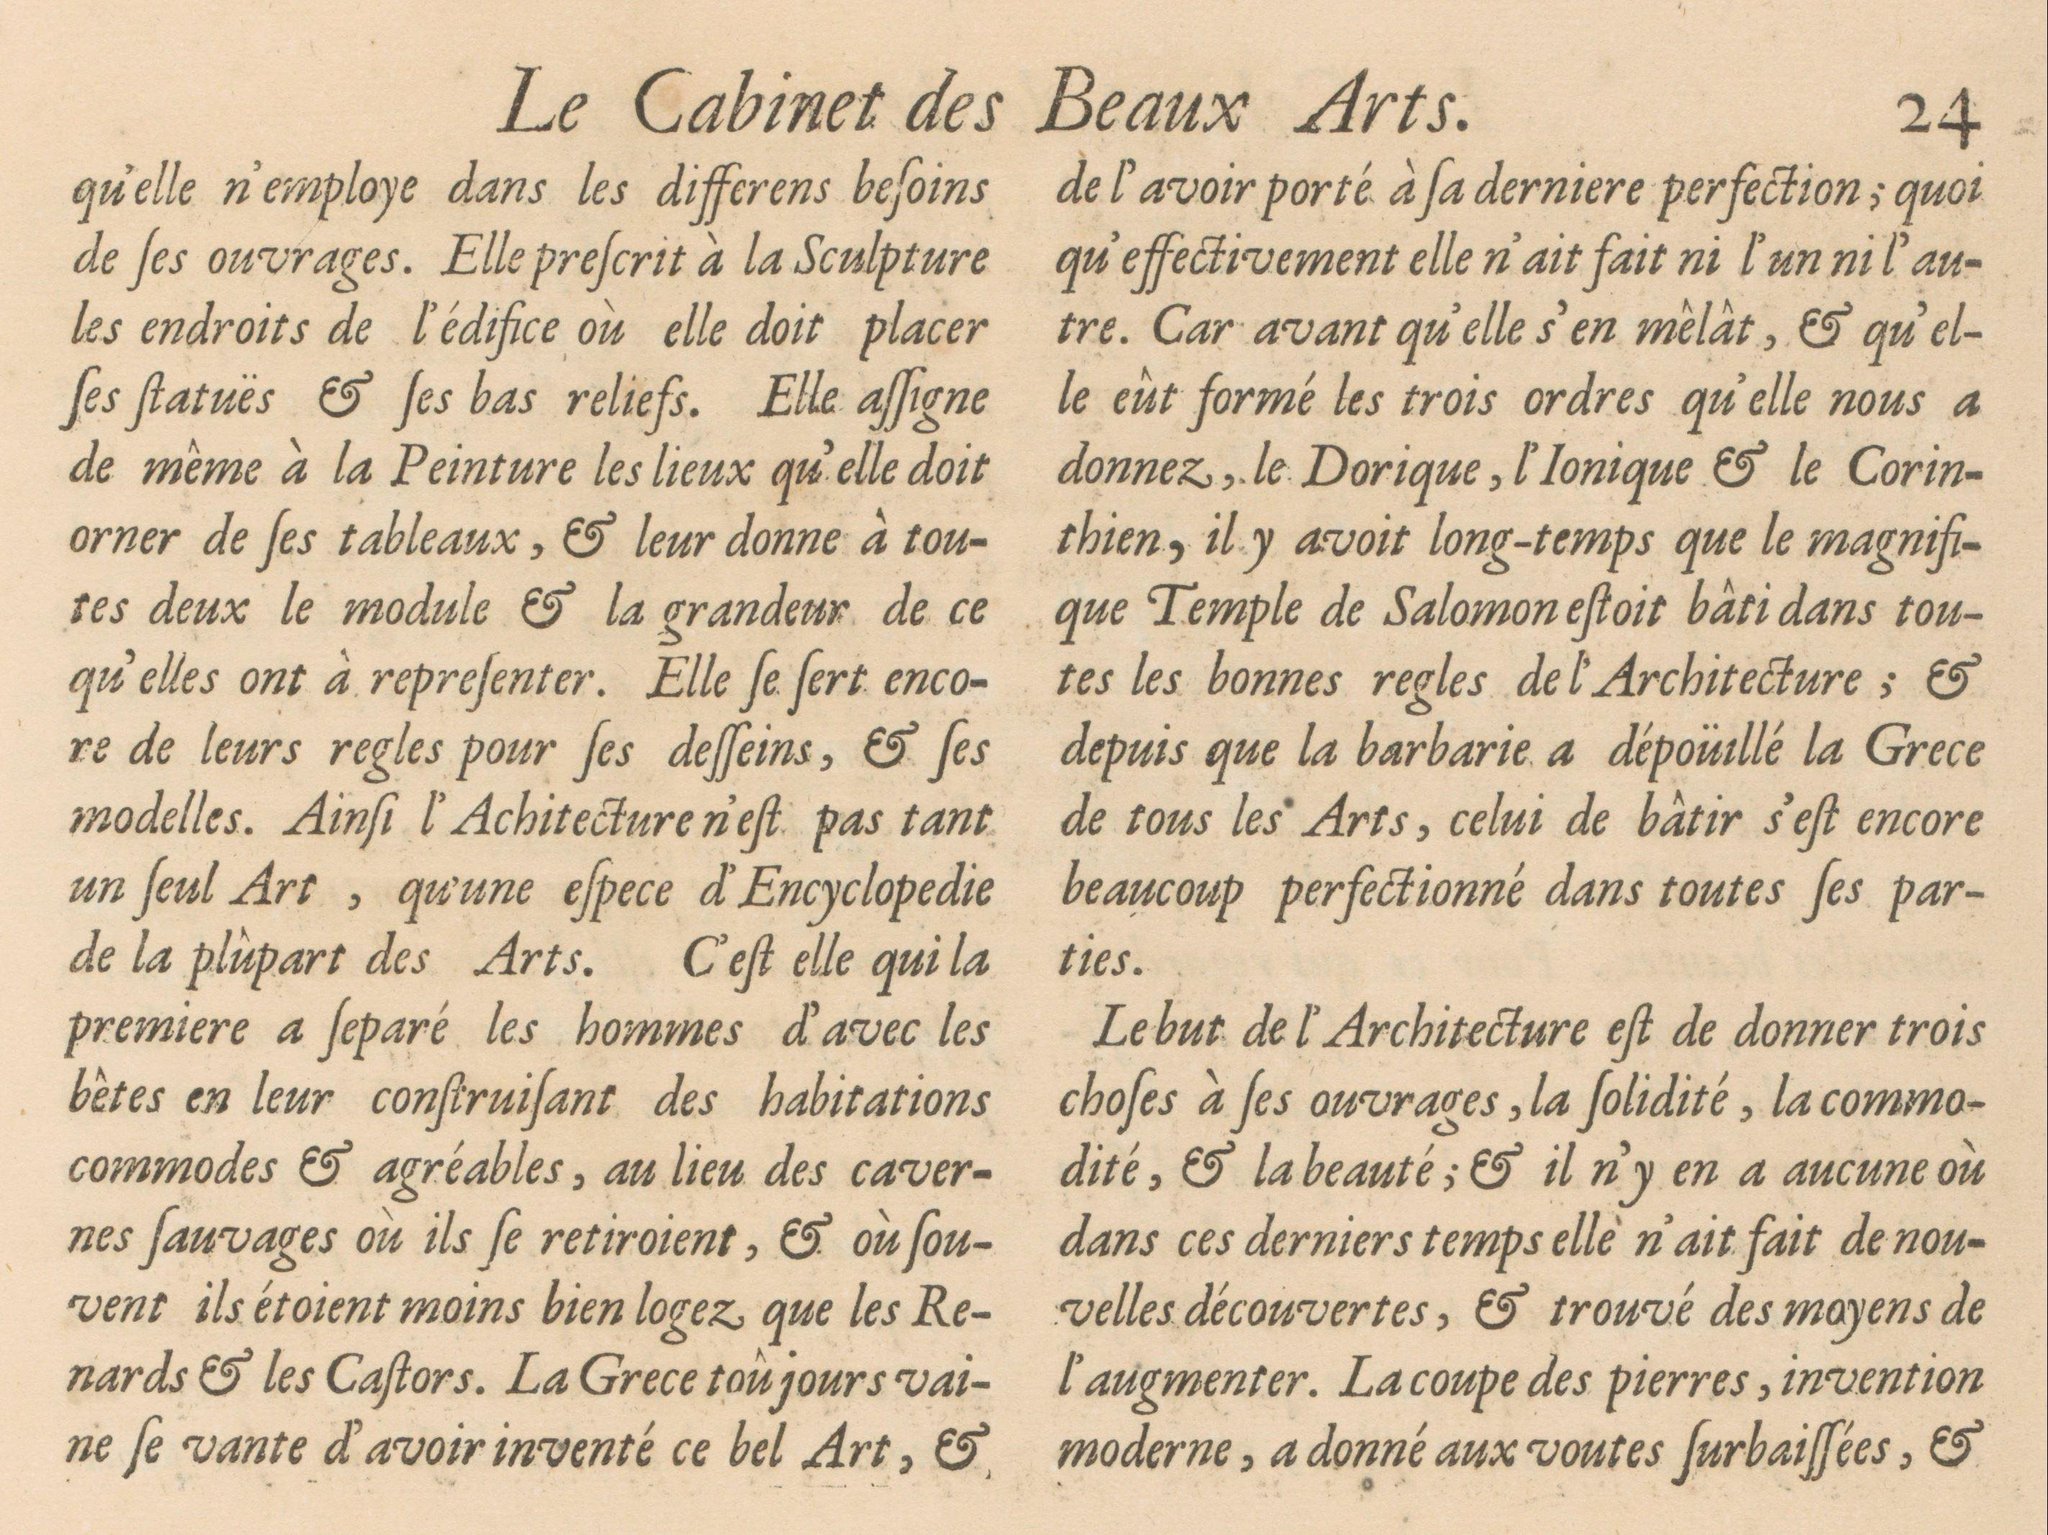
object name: text sheet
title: Tekstblad met verklaring van de prent over Architectuur, p. 24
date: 1695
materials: paper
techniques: letterpress printing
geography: paris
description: Verklaring van de prent met voorstelling van Architectuur in het Frans. Pagina 24. Tekstblad maakt deel uit van een album.